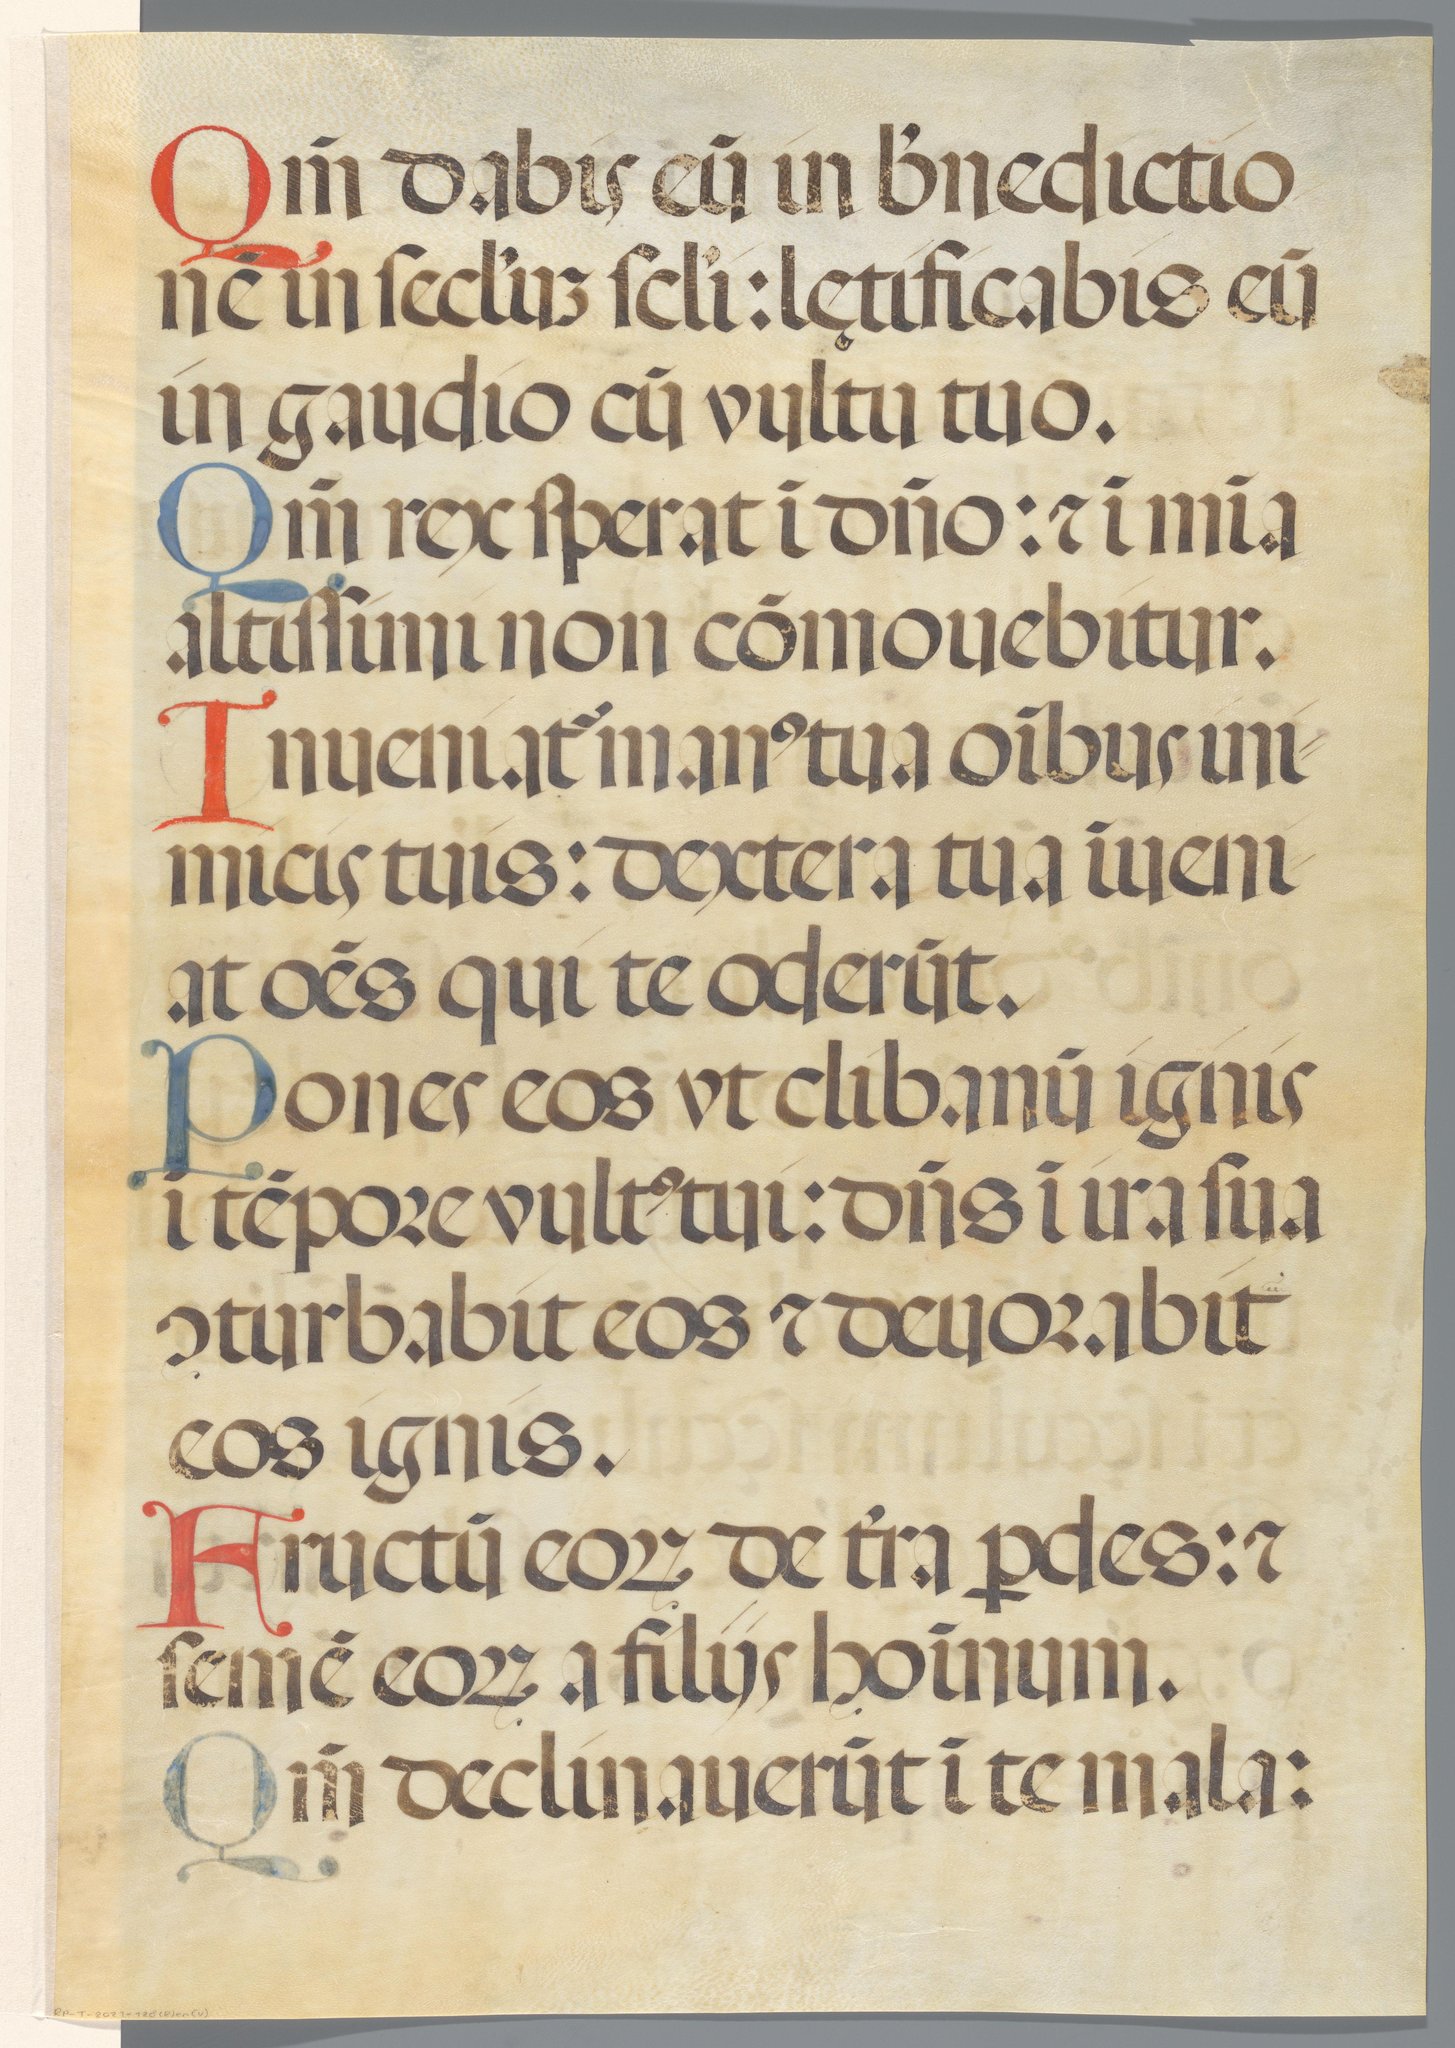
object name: page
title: Blad met handschrift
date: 1200-1599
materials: paint, ink, parchment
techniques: brush, pen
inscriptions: number: ‘141’